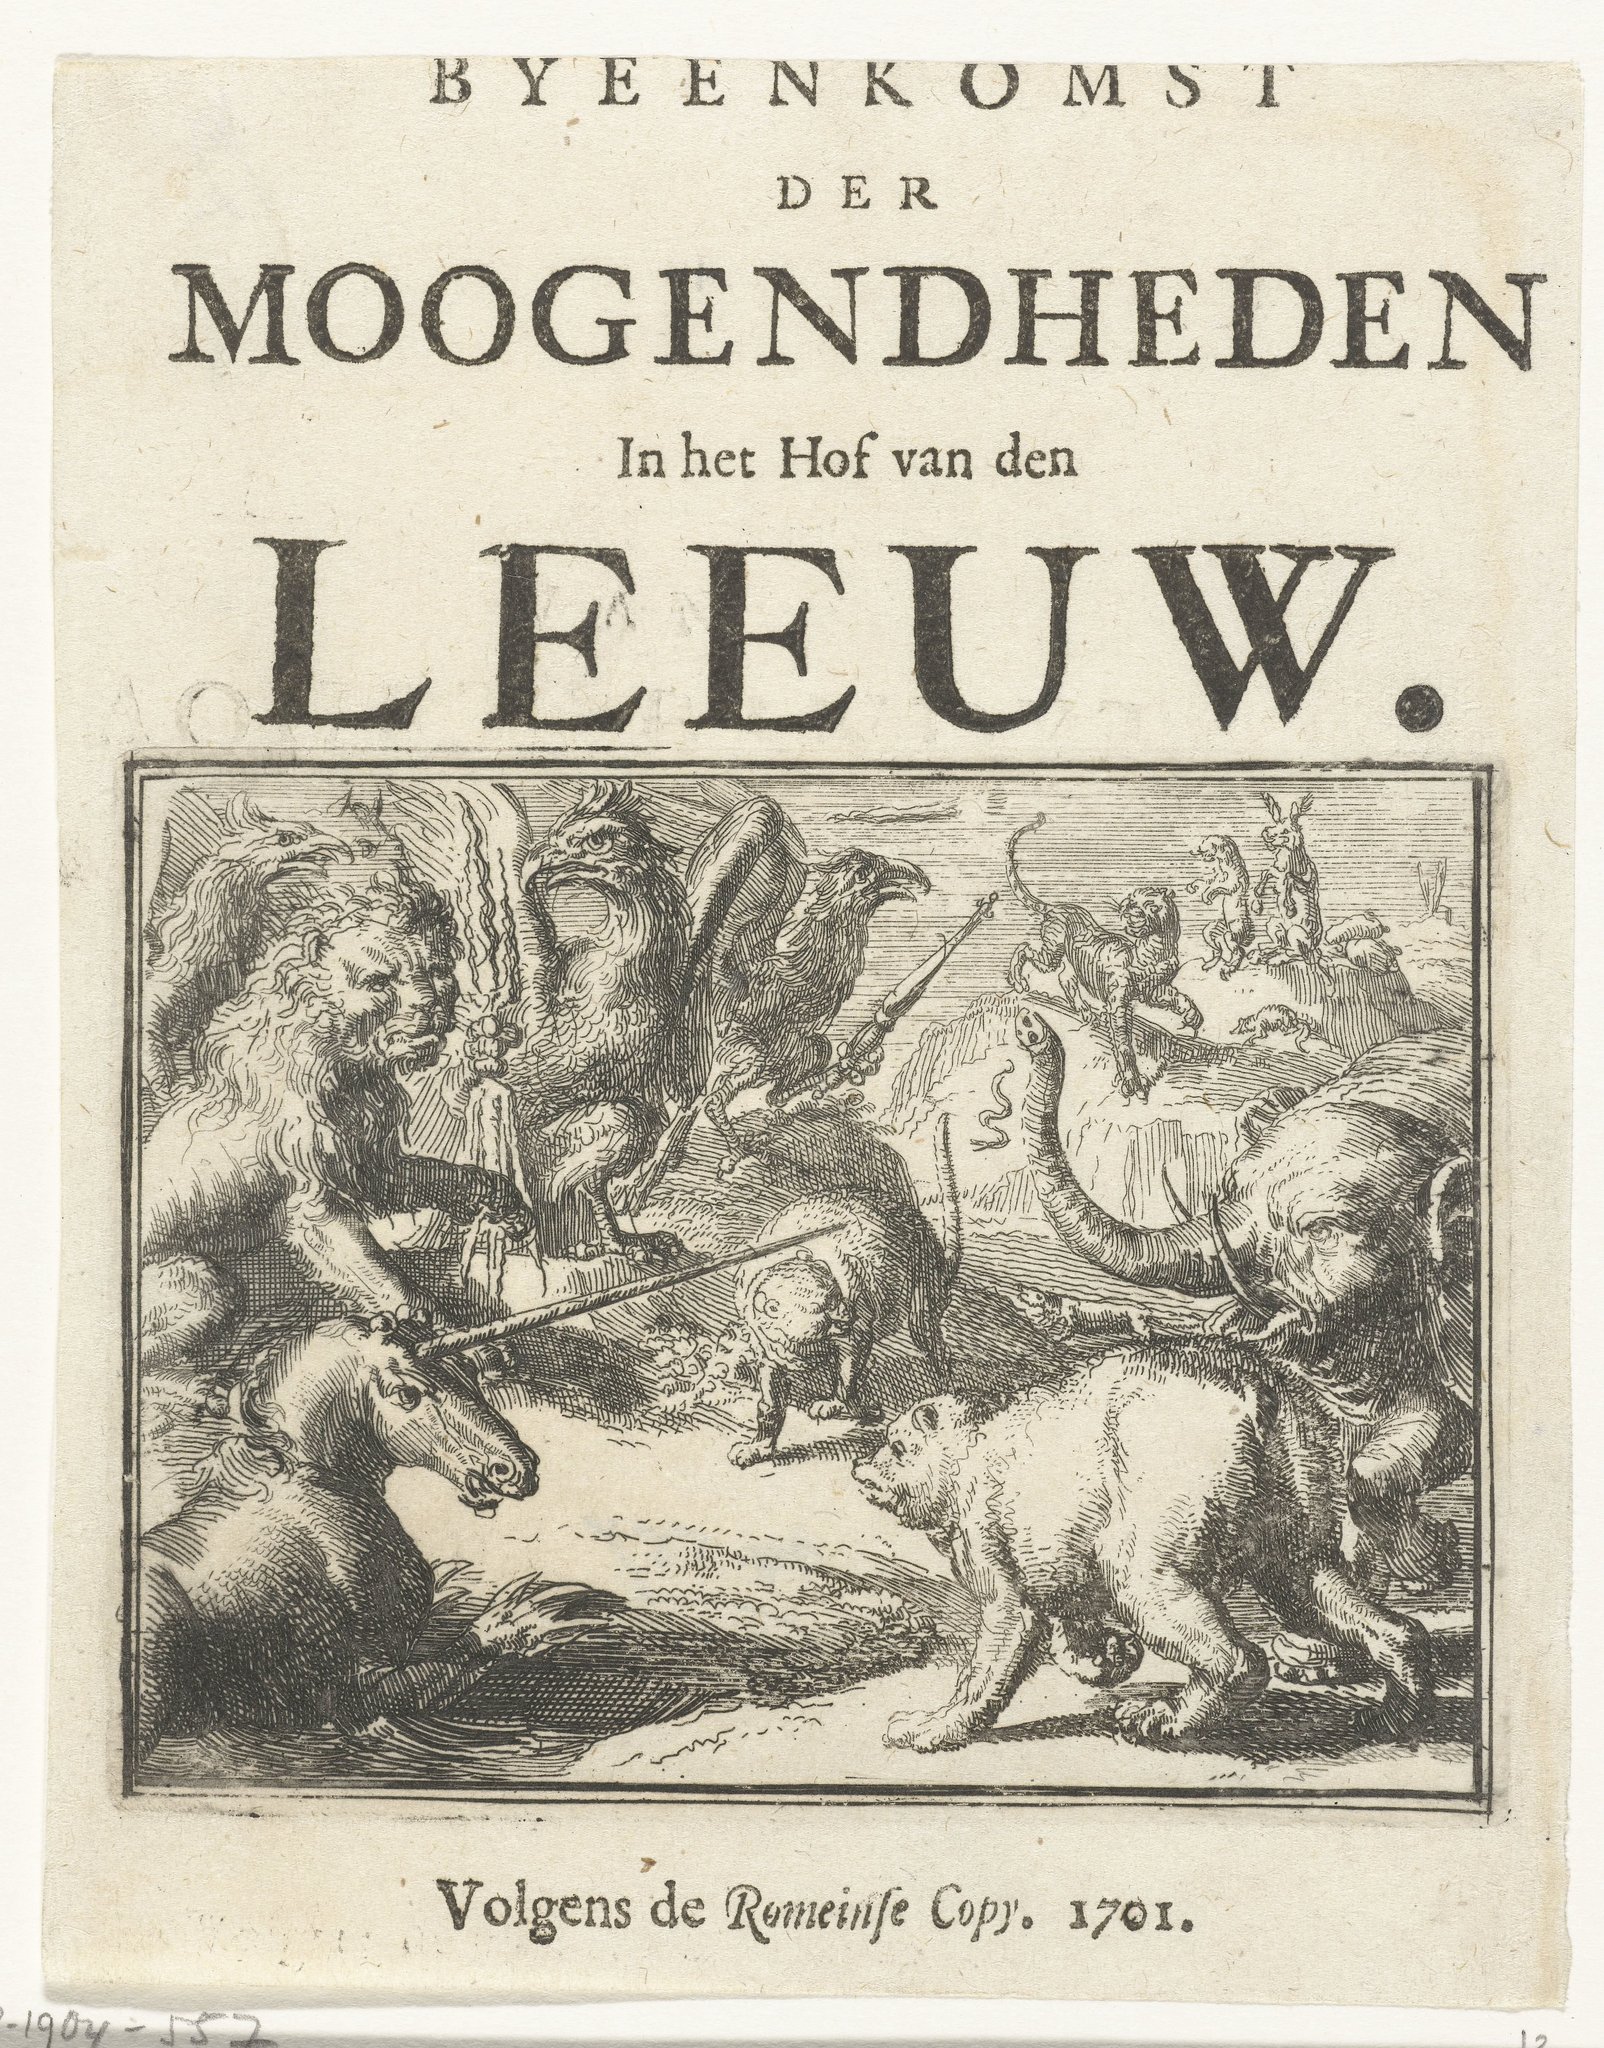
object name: print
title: Esopus in Europa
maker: romeyn de hooghe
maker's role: draughtsman, goldsmith, painter, print maker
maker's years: 1645-1708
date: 1701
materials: paper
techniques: etching, letterpress printing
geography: northern netherlands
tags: spaanse successieoorlog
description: Titelblad voor het pamflet: Byeenkomst der Moogendheden in het Hof van den Leeuw, 1701. Bijeenkomst van de leeuw met de eenhoorn (Engeland), olifant (Denemarken), beer (Zweden), adelaar (keizerrijk) en een kat (Holland) waarin de trouweloosheid van de tijger (Frankrijk) wordt besproken.